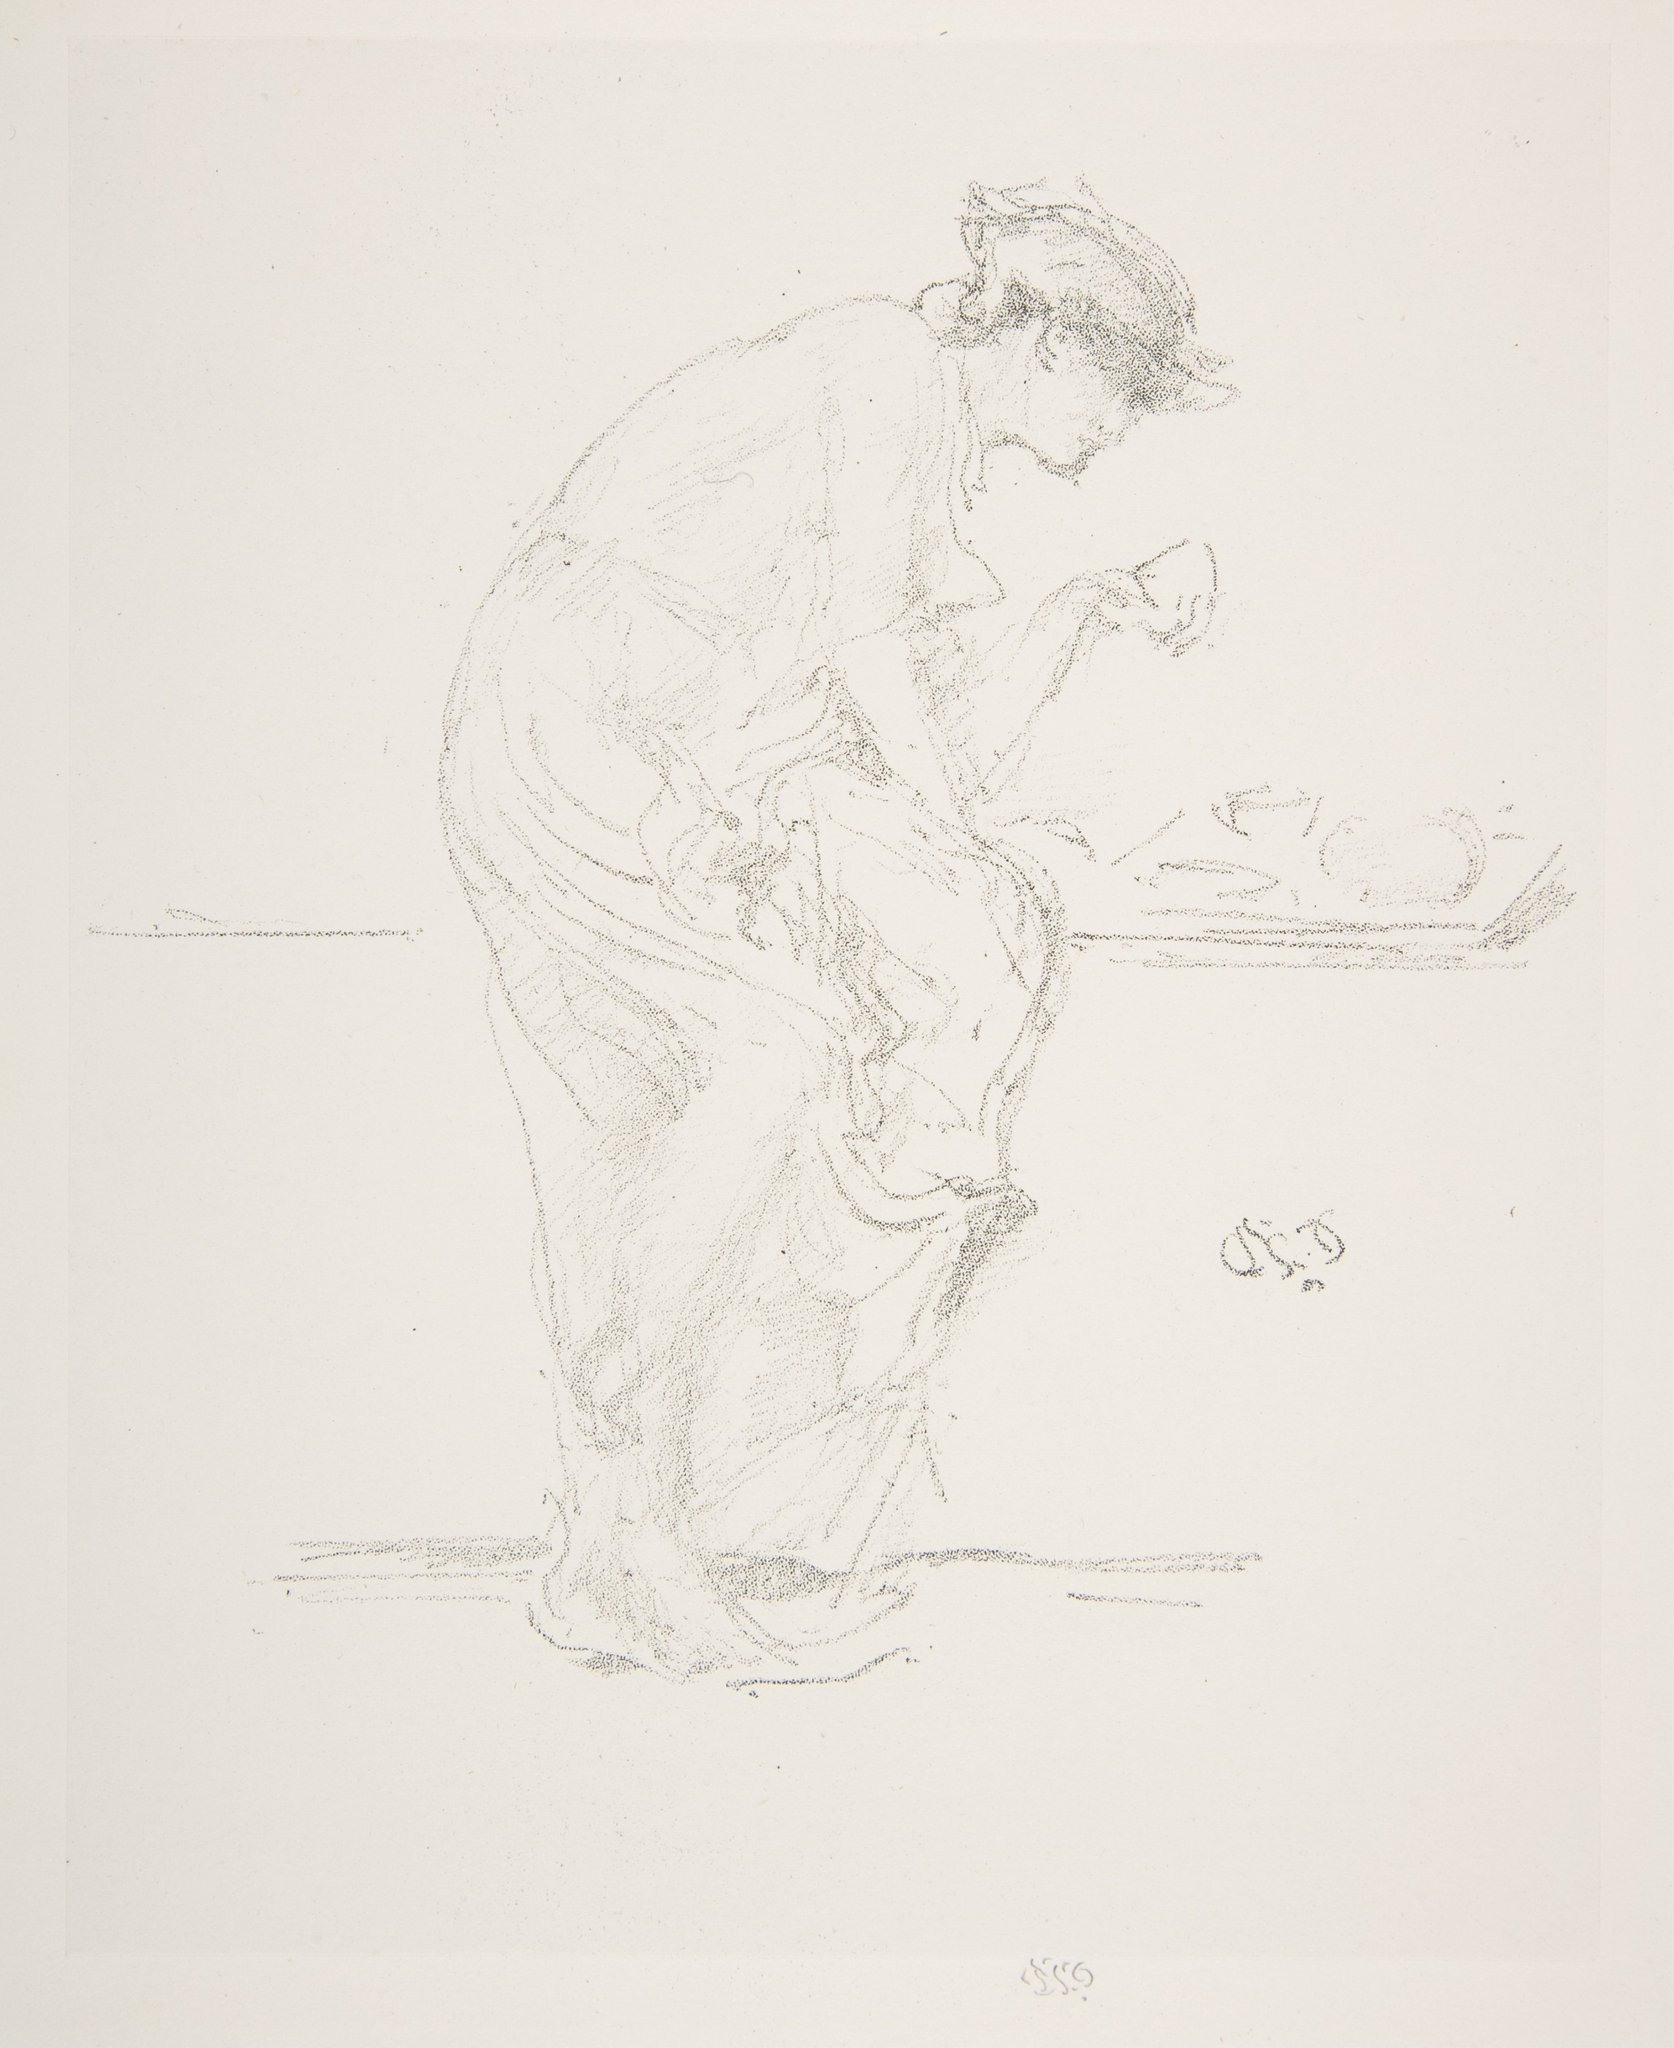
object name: print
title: The Horoscope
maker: james mcneill whistler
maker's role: artist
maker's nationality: american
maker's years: 1834-1903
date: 1889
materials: chine, ivory, paper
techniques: printing, lithography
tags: women